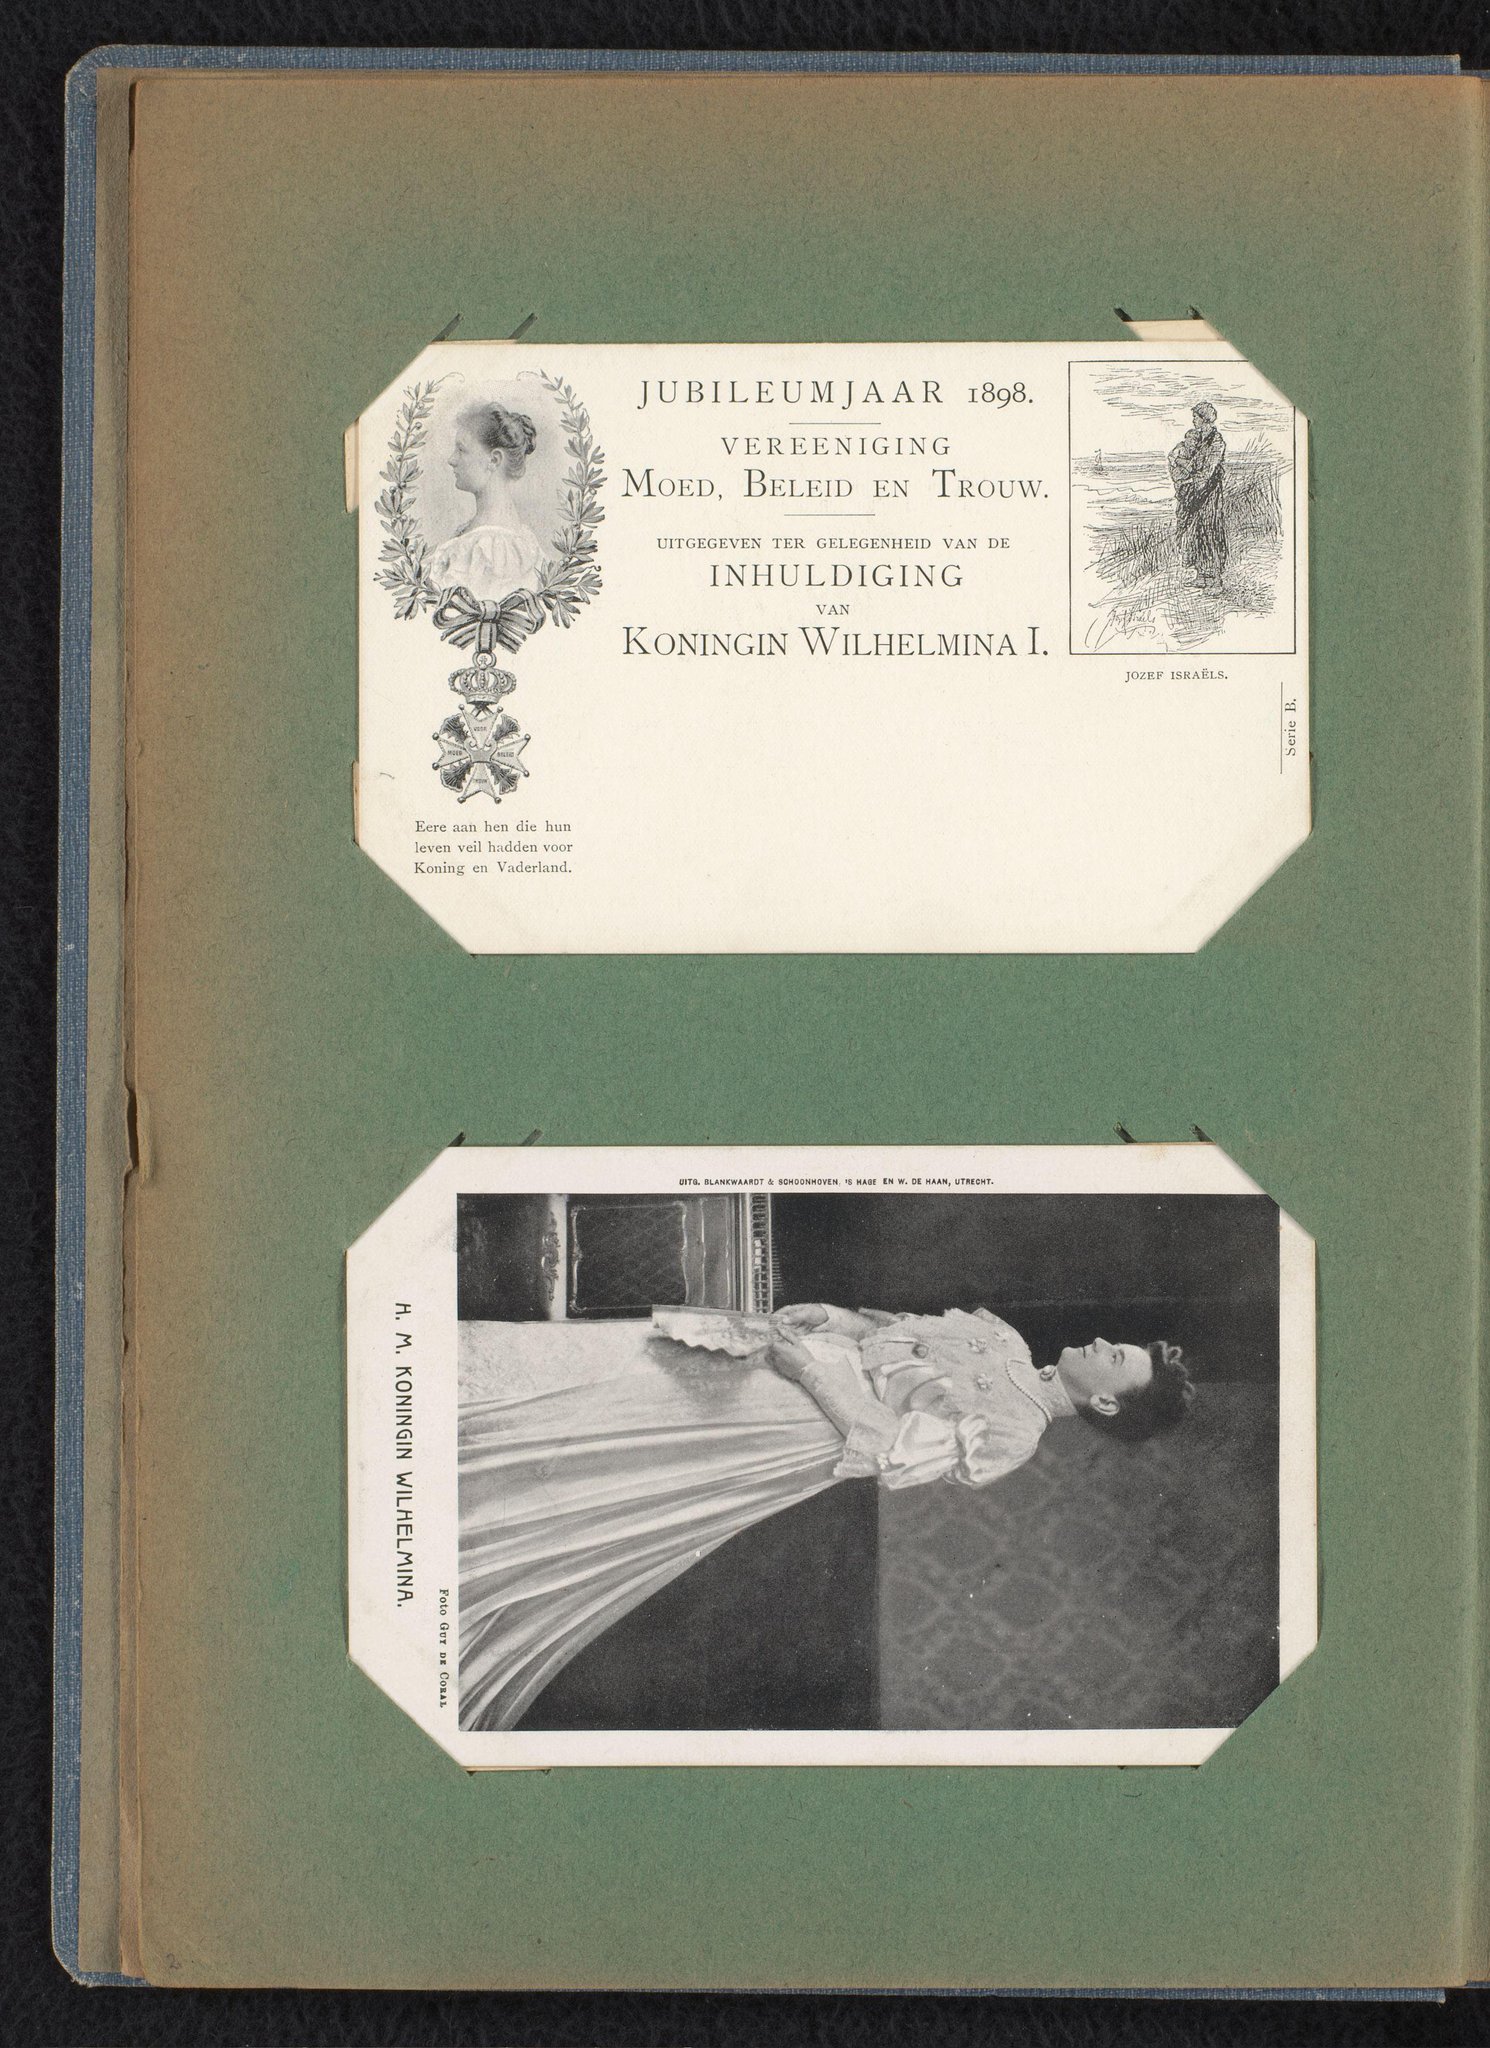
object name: ansichtkaart, prentbriefkaart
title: Twee prentbriefkaarten met portretten van koningin Wilhelmina en een fotoreproductie van een getekende vissersvrouw door Jozef Israëls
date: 1898-1905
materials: cardboard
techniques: letterpress printing, printing block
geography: amsterdam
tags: the hague, print maker, wilhelmina of the netherlands, historical persons - bb - woman, queen, mother and baby or young child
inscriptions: inscription: ‘H.M. Koningin Wilhelmina’, inscription: ‘Jubileumjaar 1898 (...)’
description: Deze prenten maken deel uit van een album.